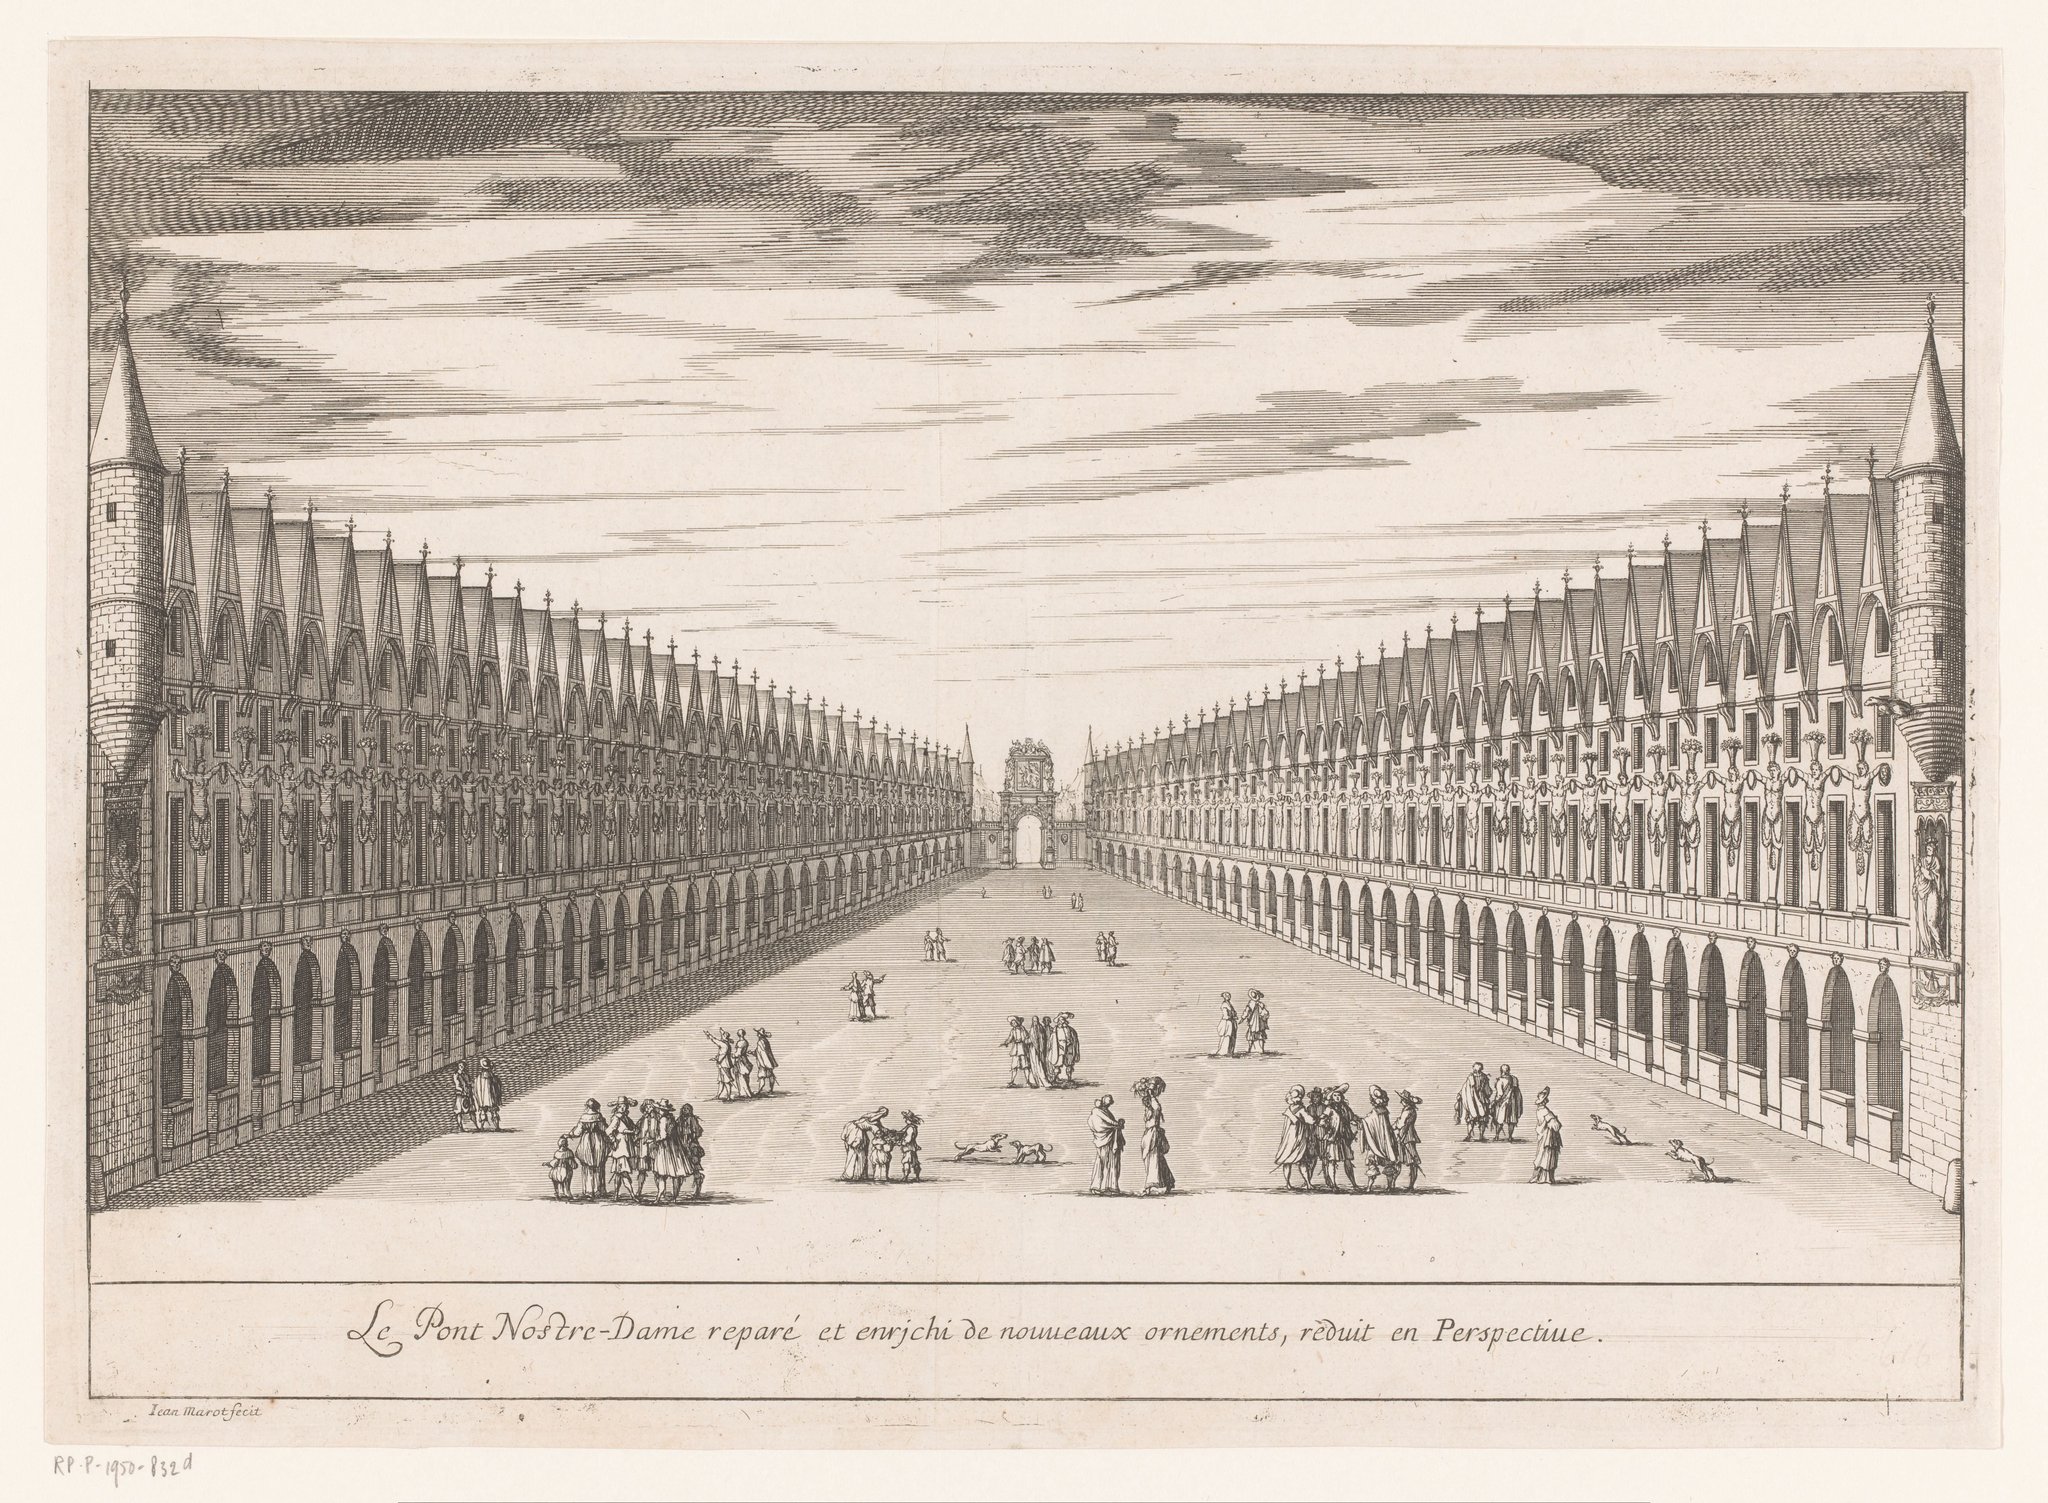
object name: print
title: Le Pont Nostre-Dame reparé et enrichi de nouveaux ornements, réduit en Perspective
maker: jean marot (i)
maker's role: print maker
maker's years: 1619-1679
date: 1662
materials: paper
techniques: engraving, etching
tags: city-view in general; 'veduta', bridge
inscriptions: collector's mark: Lugt 2228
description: Prent gebruikt voor: Tronçon, Jean. Entrée triomphante de leurs Majestez Louis XIV roy de France et de Navarre et Marie Therese d'Autriche son epouse dans la ville de Paris (...). Parijs: Pierre Le Petit; Thomas Joly en Louis Bilaine, 1662.